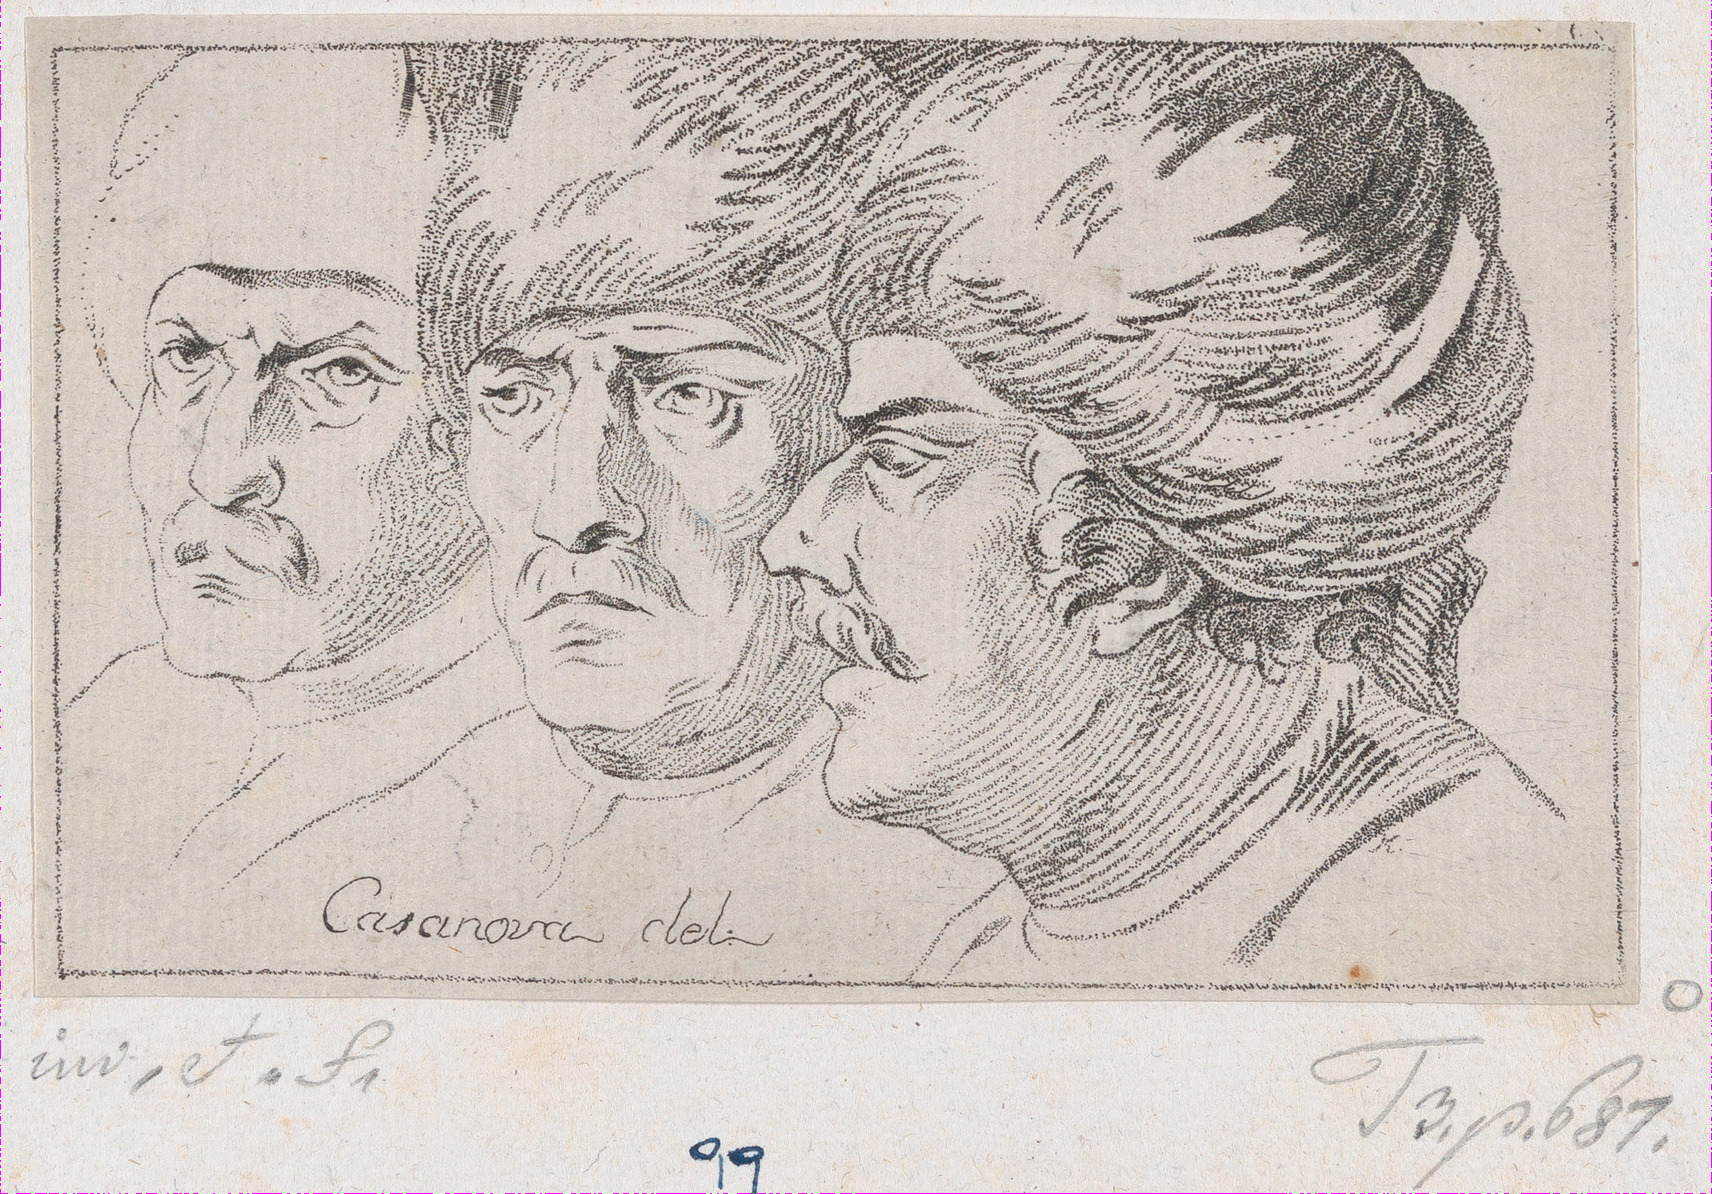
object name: print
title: Donkey carrying a flag on its back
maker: francesco casanova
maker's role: artist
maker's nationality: italian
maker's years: 1727-1803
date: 1701-1800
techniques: etching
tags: men,portraits,profiles